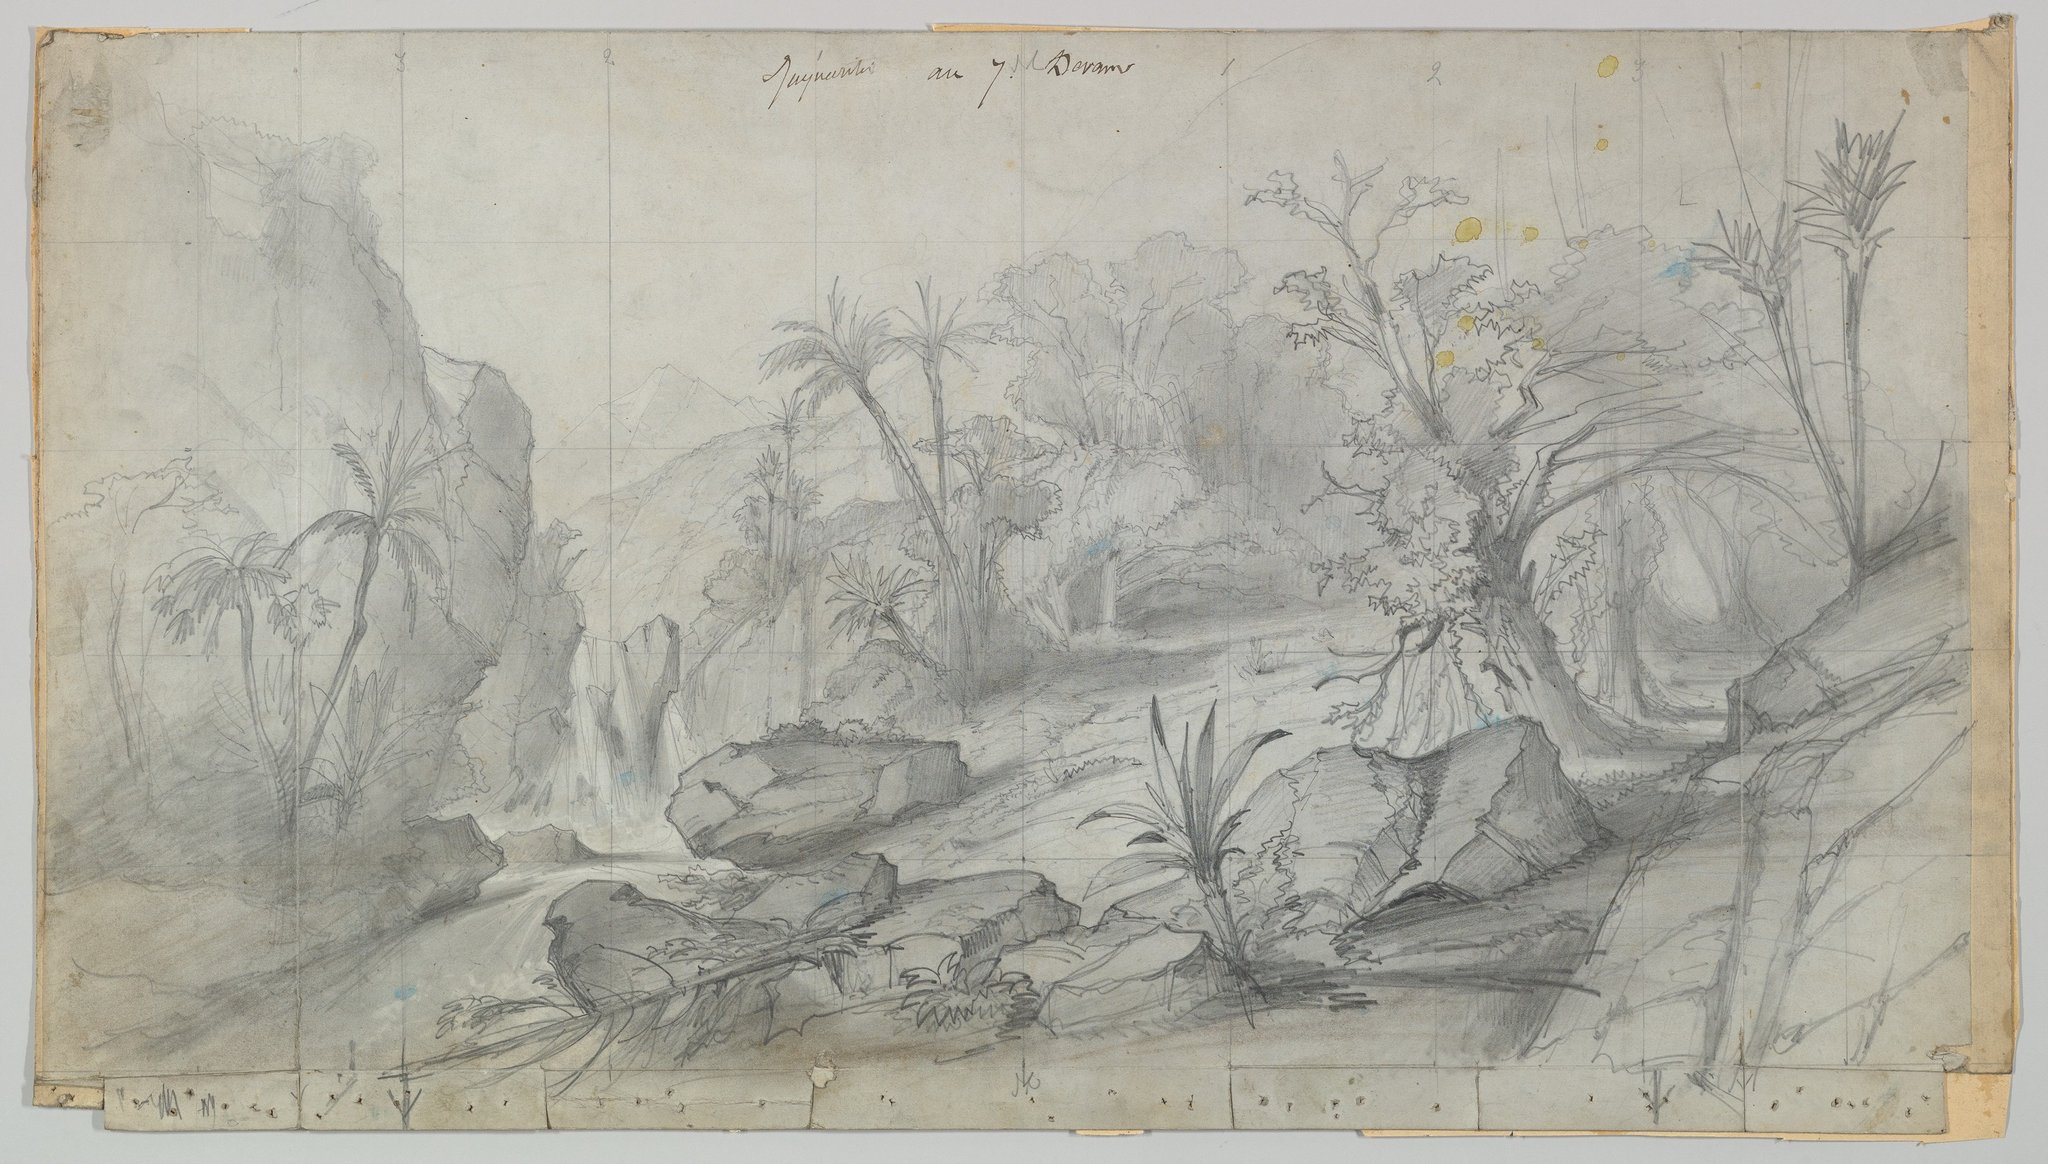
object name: drawing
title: Design for a Stage Set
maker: eugène cicéri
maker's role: artist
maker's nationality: french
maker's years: 1813-1890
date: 1830-1890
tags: landscapes,stage design